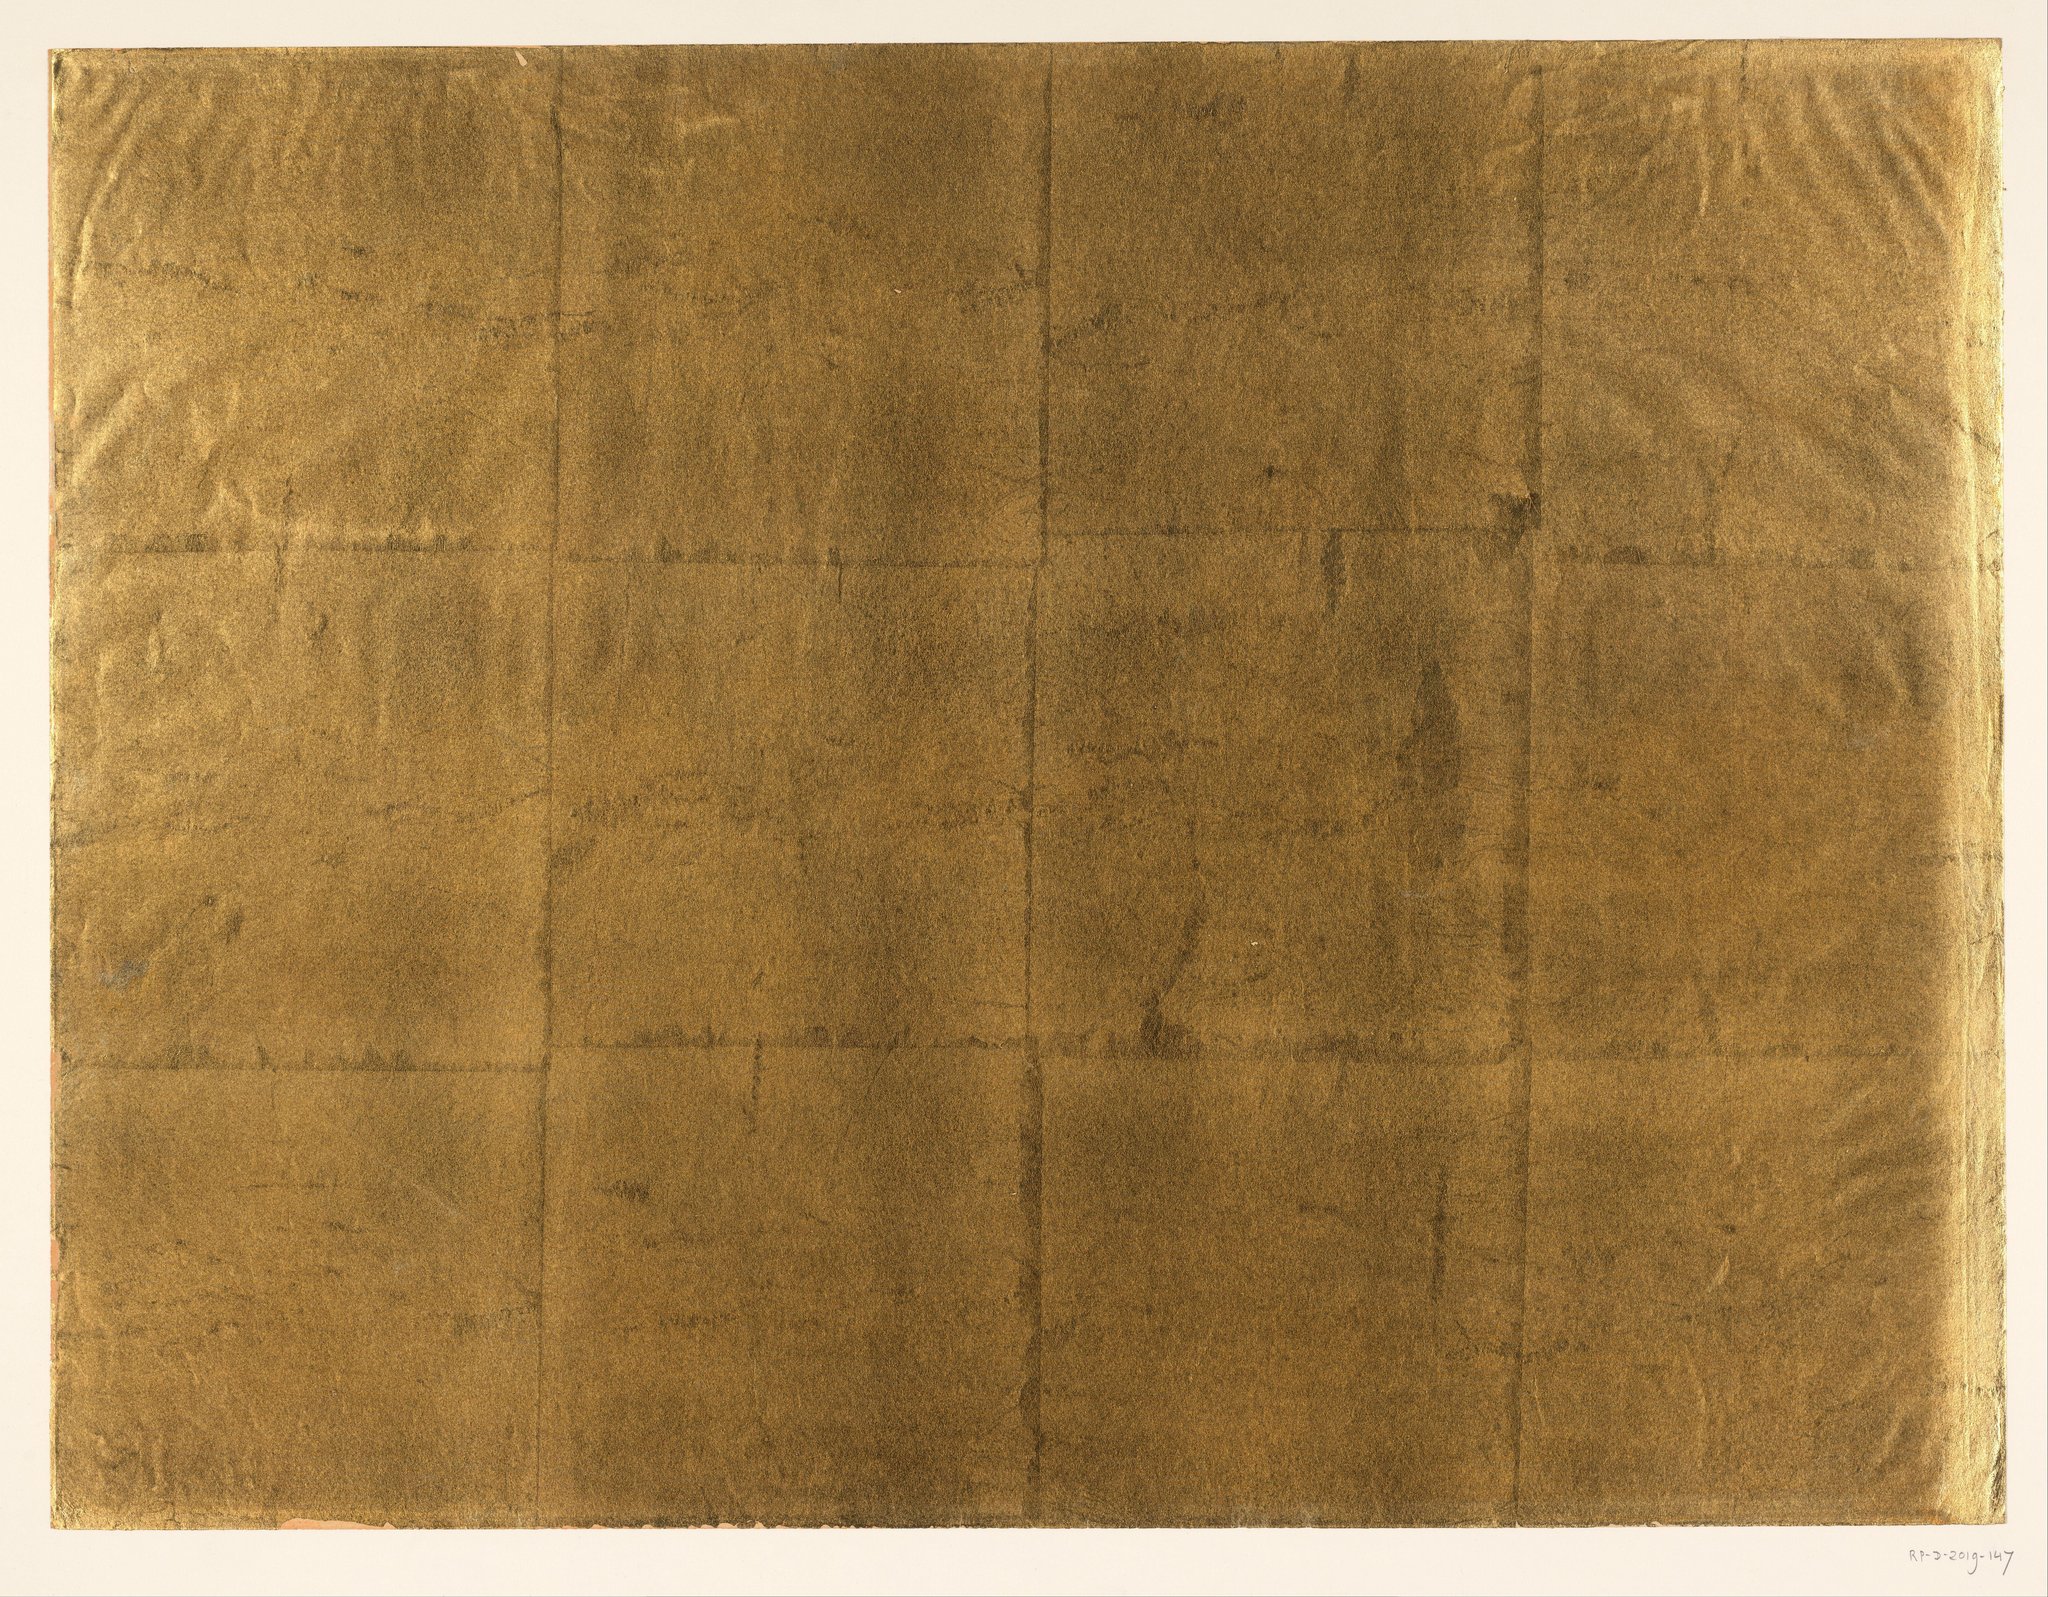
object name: metallic paper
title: Blad effen goudkleurig metaalpapier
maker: Anonymous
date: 1850-1950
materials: gold leaf, paint, paper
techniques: painting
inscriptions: collector's mark: Lugt 2228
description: Blad effen goudkleurig metaalpapier, aangebracht in vierkanten.